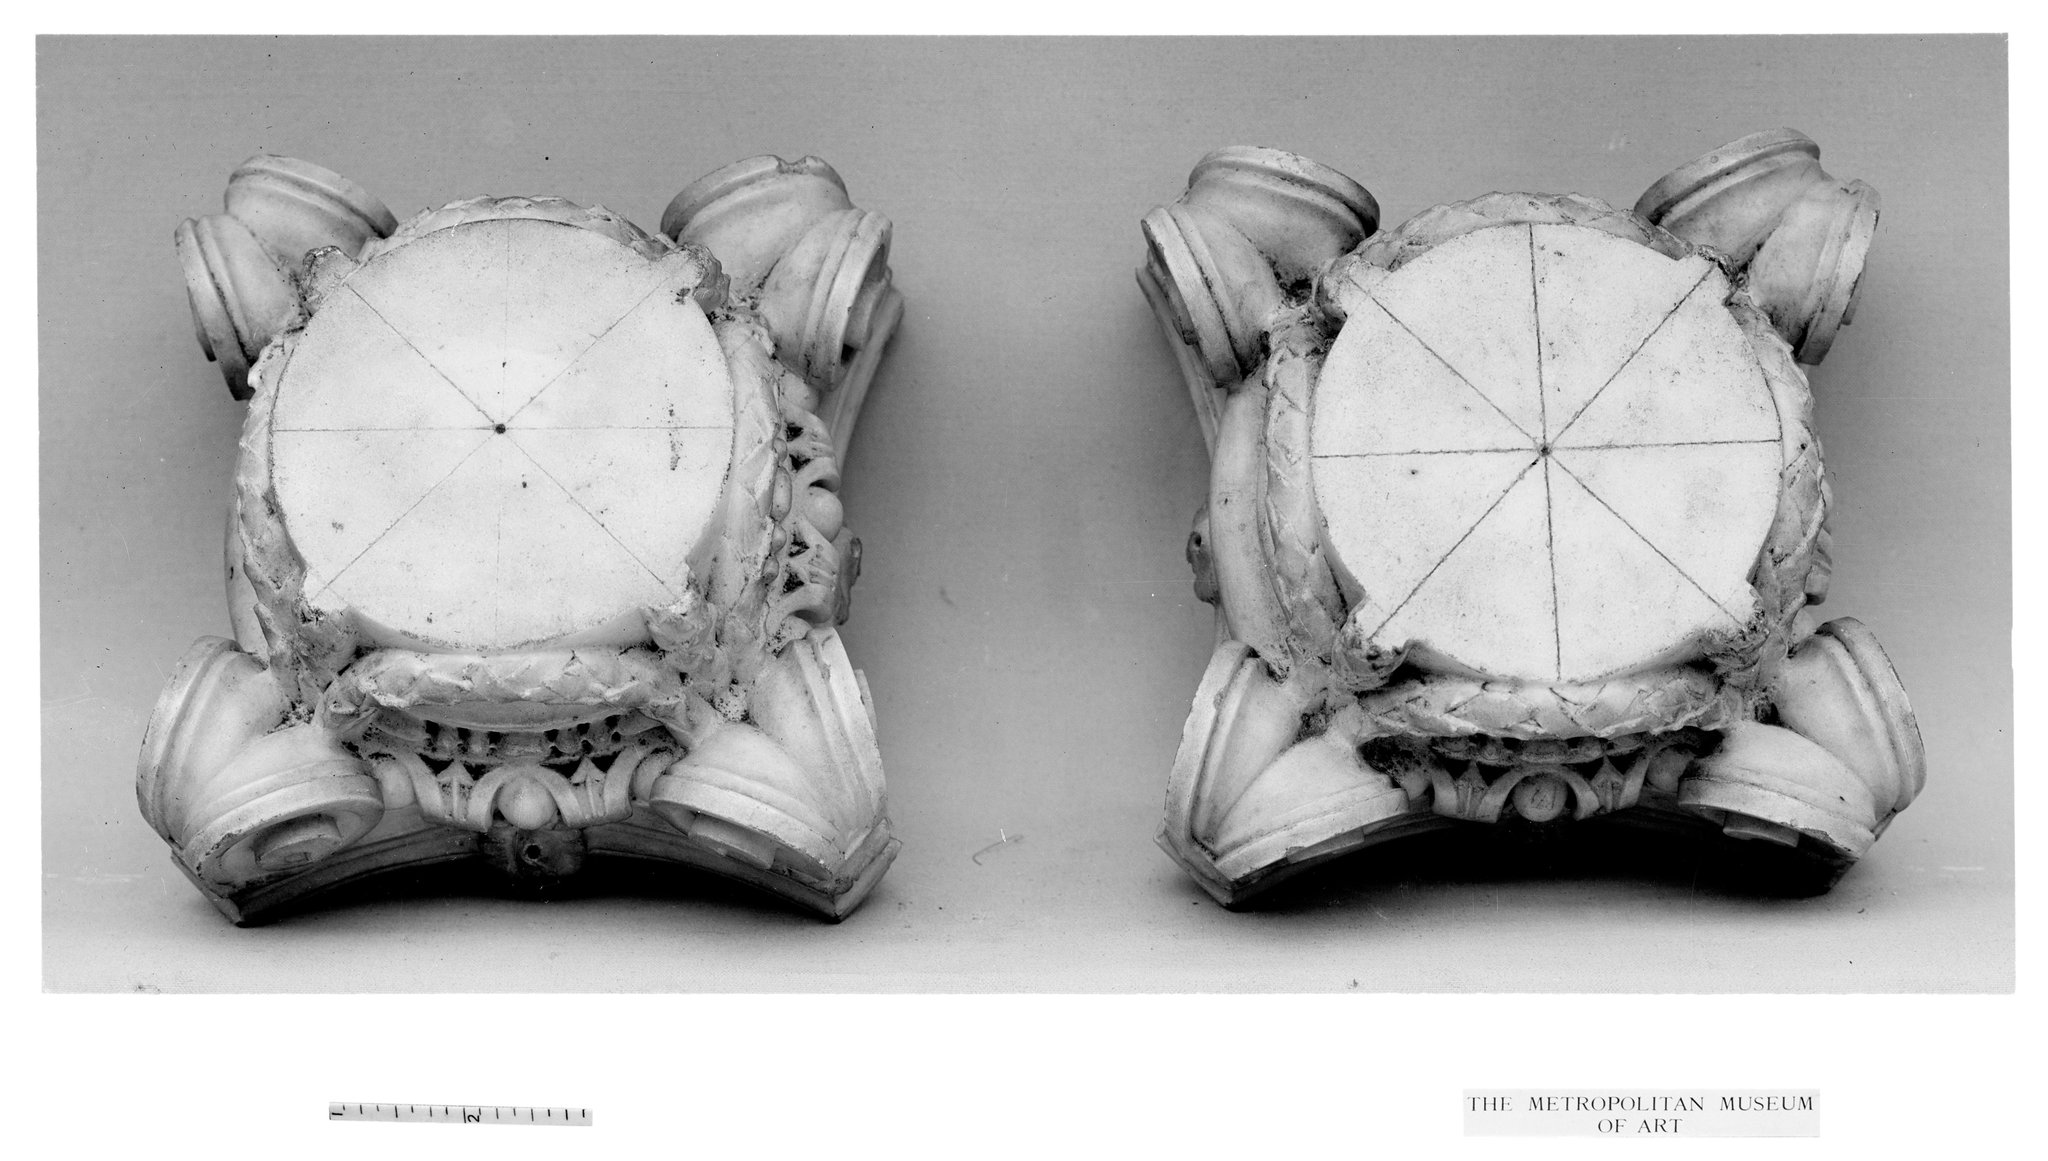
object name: capital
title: Capital (one of a pair)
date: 1701-1800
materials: marble